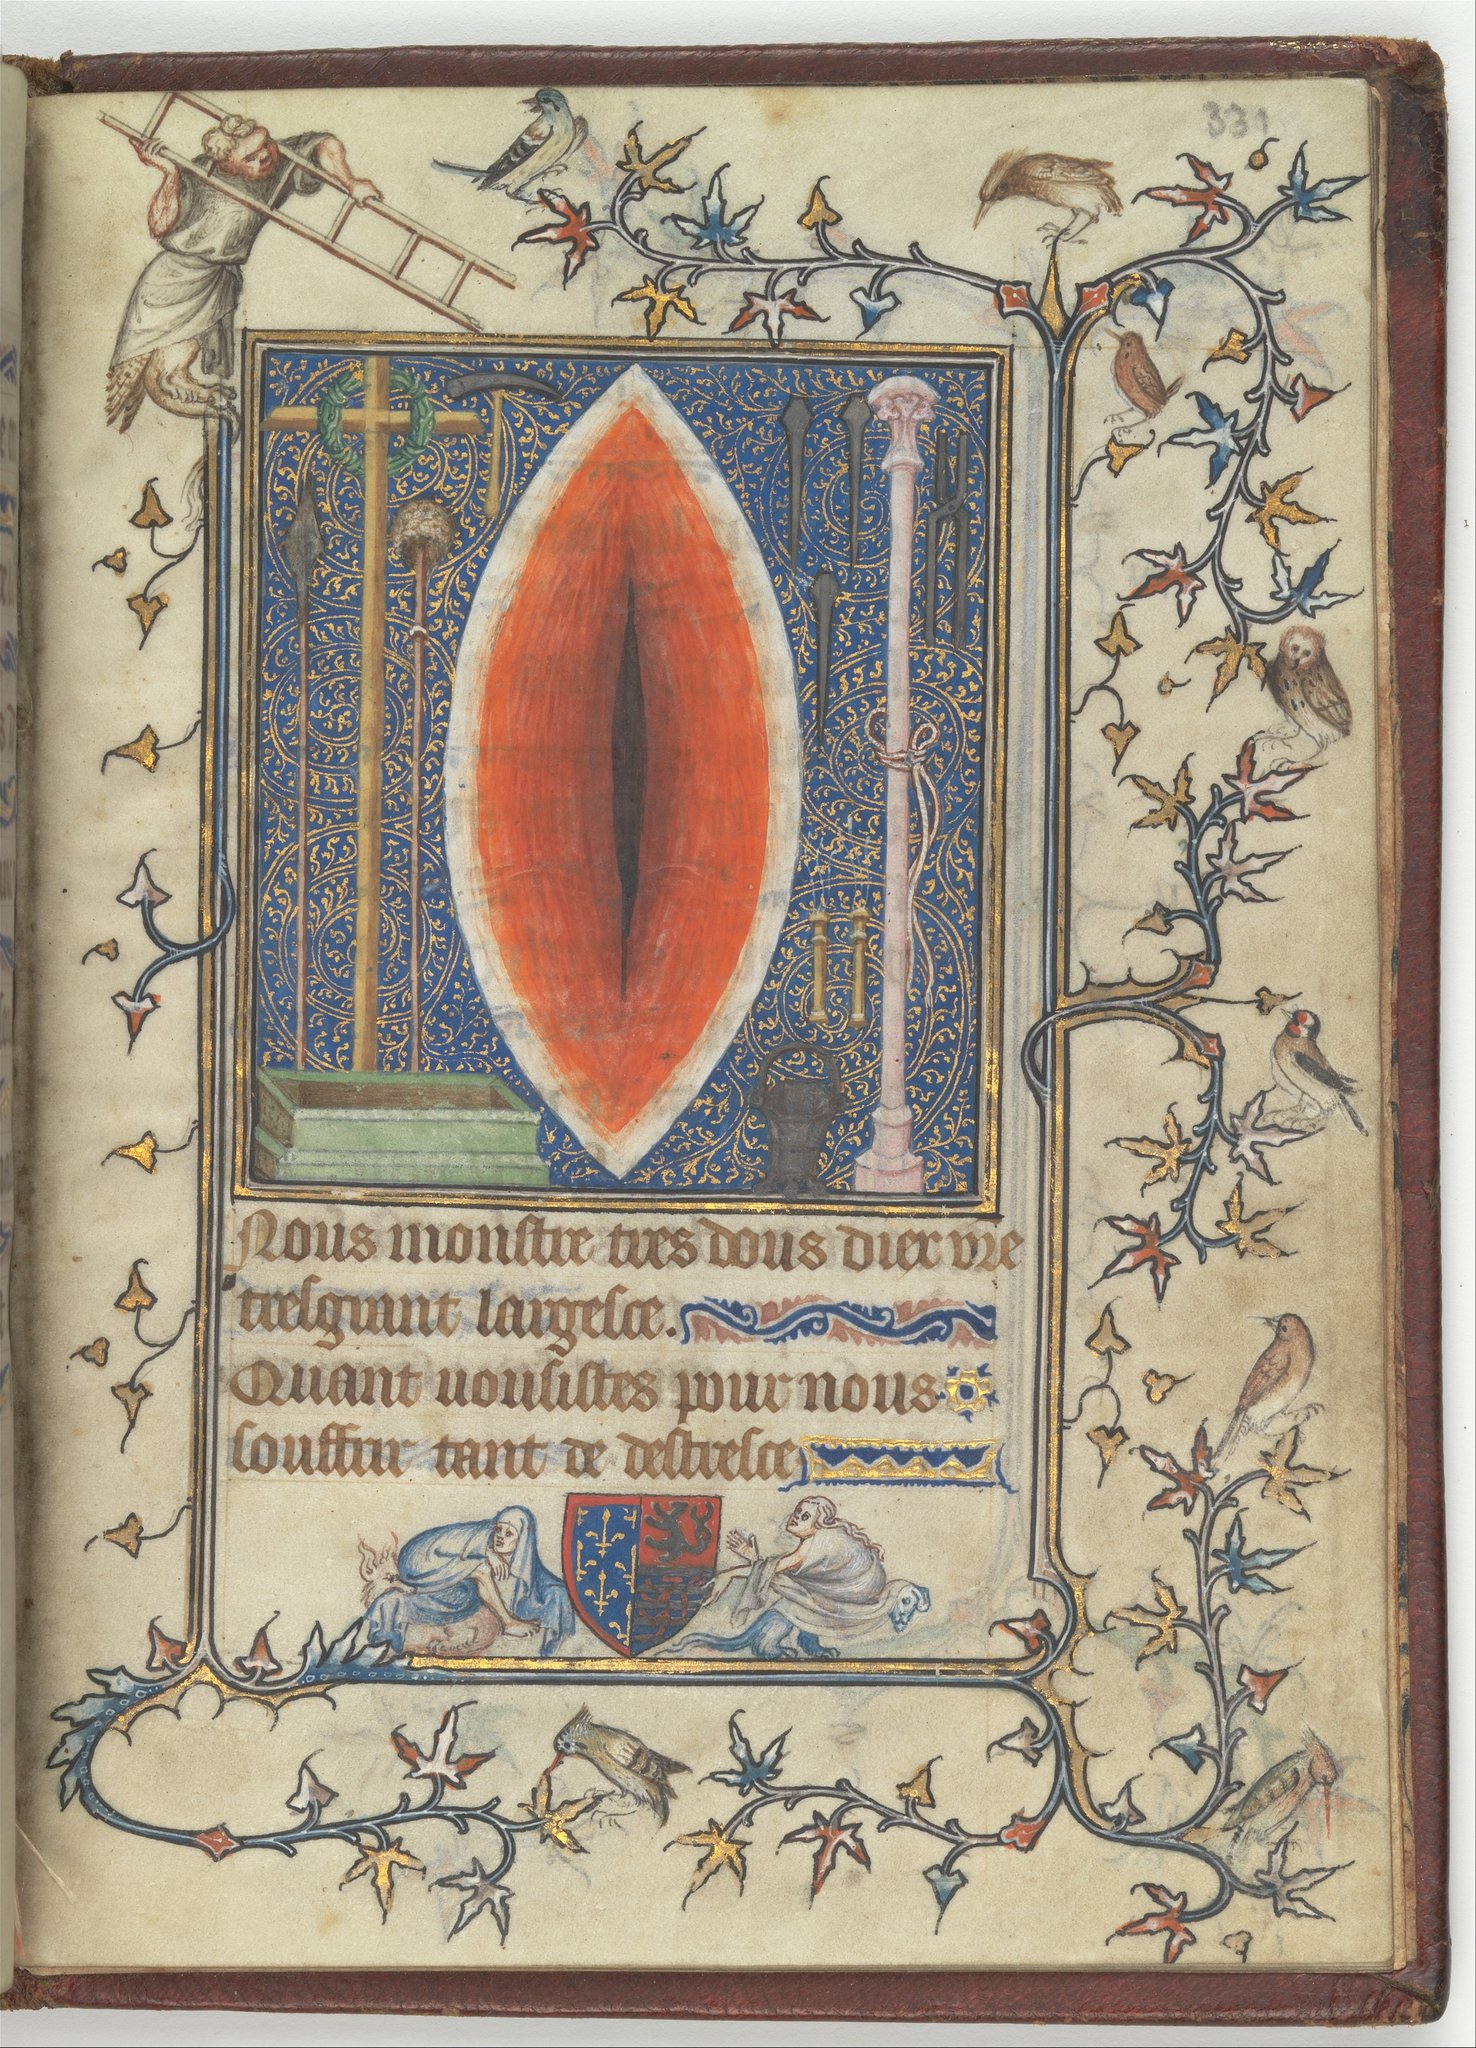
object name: psalter and hour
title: The Prayer Book of Bonne of Luxembourg, Duchess of Normandy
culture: french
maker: jean le noir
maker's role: artist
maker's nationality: french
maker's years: 1331-1375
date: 1349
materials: gold, ink, paint, parchment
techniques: grisaille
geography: france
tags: animals,birds,skeletons,men,horses,christ,coat of arms